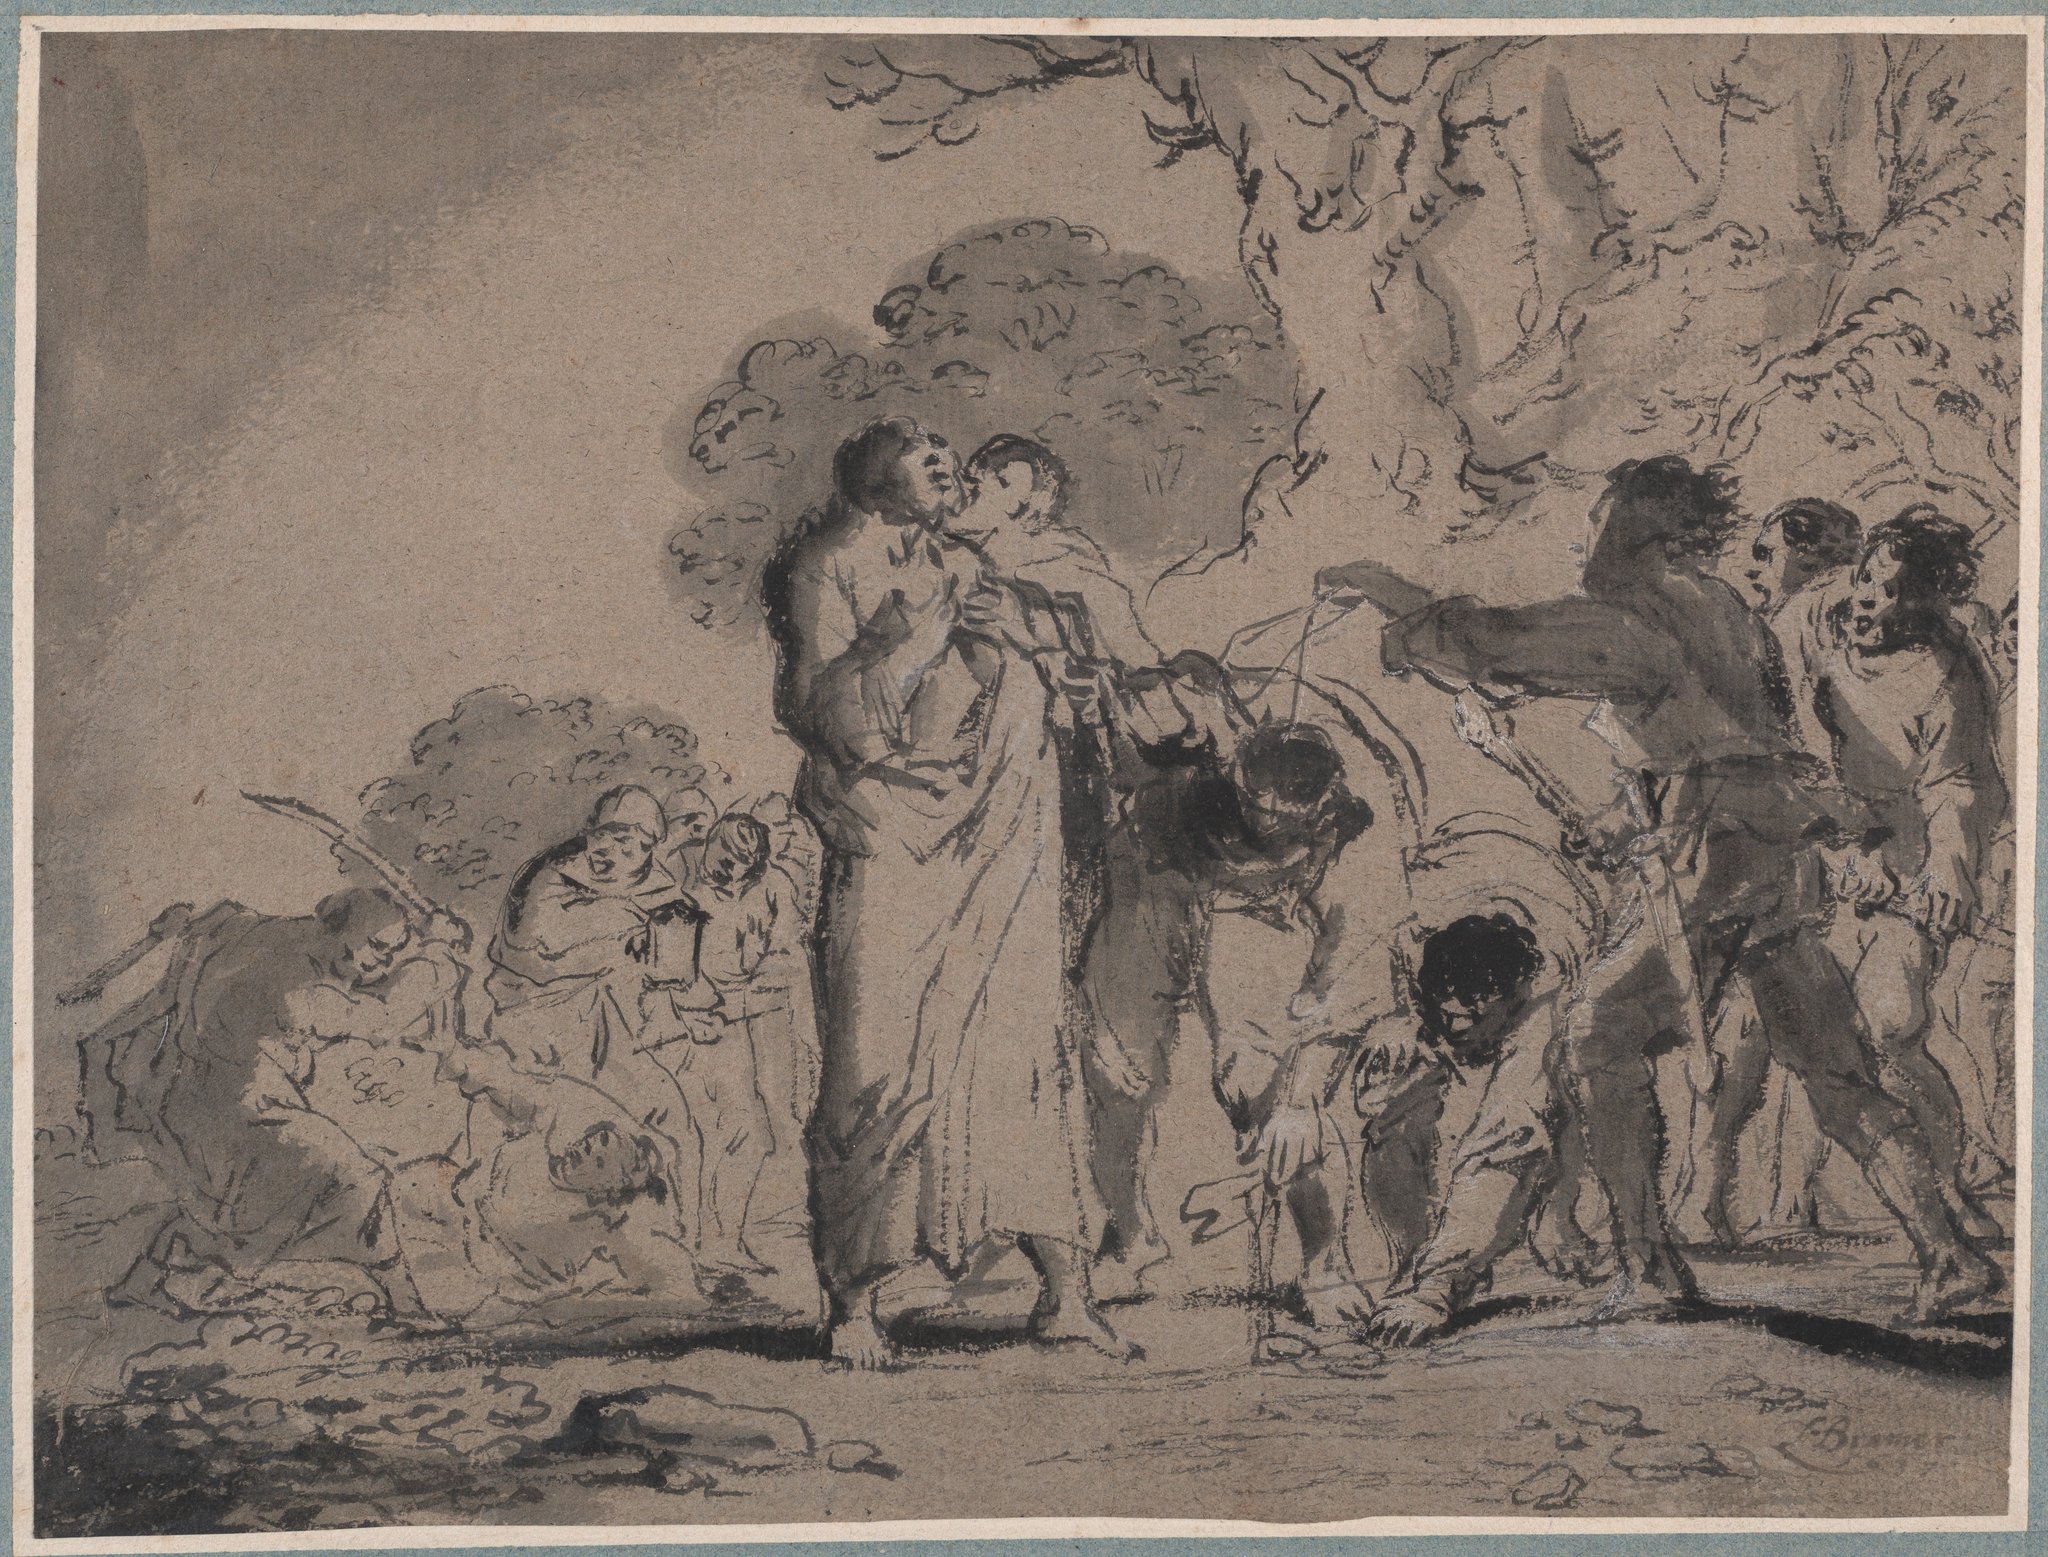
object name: drawing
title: Betrayal of Christ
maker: leonaert bramer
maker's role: artist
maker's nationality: dutch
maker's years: 1596-1674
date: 1637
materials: chalk, ink, paper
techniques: brush, wash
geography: netherlands